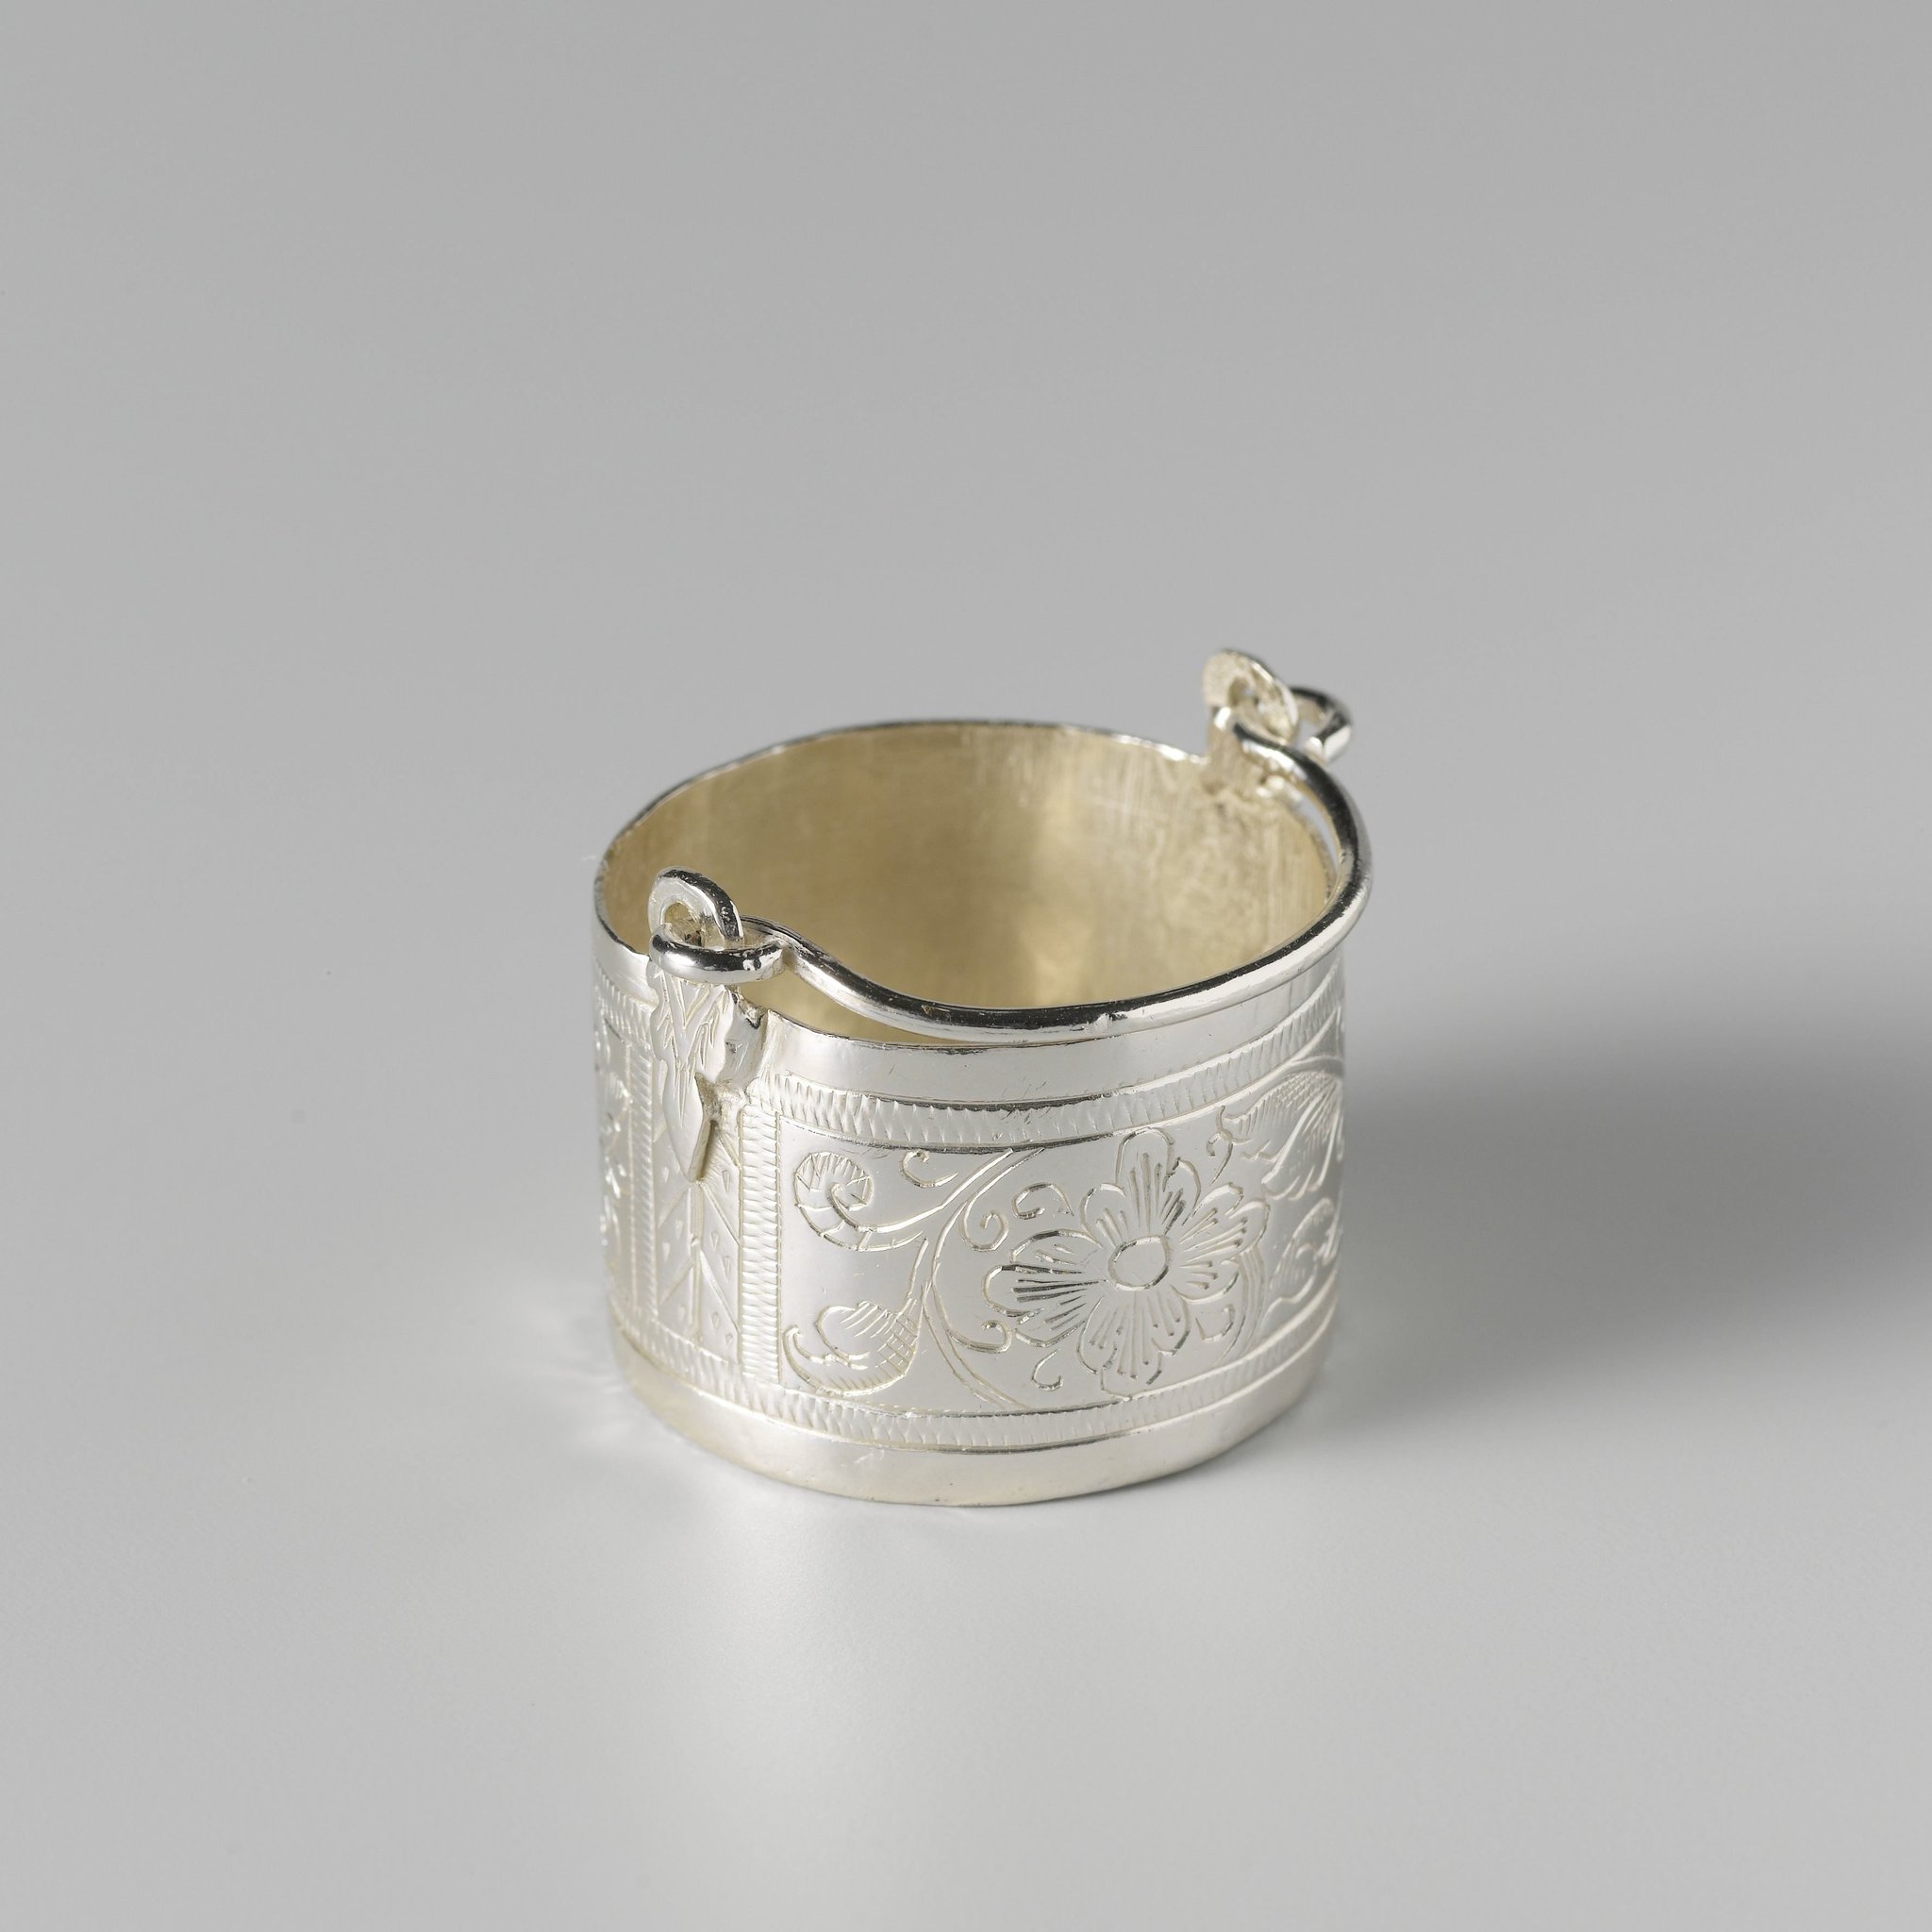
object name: miniature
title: Visketel met zes vissen op de bodem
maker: Anonymous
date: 1700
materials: silver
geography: netherlands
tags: container of metal: bucket, can, canister, drum, tin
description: Visemmer met hengsel. Op de buitenwand van de emmer zijn binnen twee zig-zag randen bloemen gegraveerd. Op de bodem aan de binnenkant zijn zes vissen gegraveerd. De emmer is niet gemerkt.